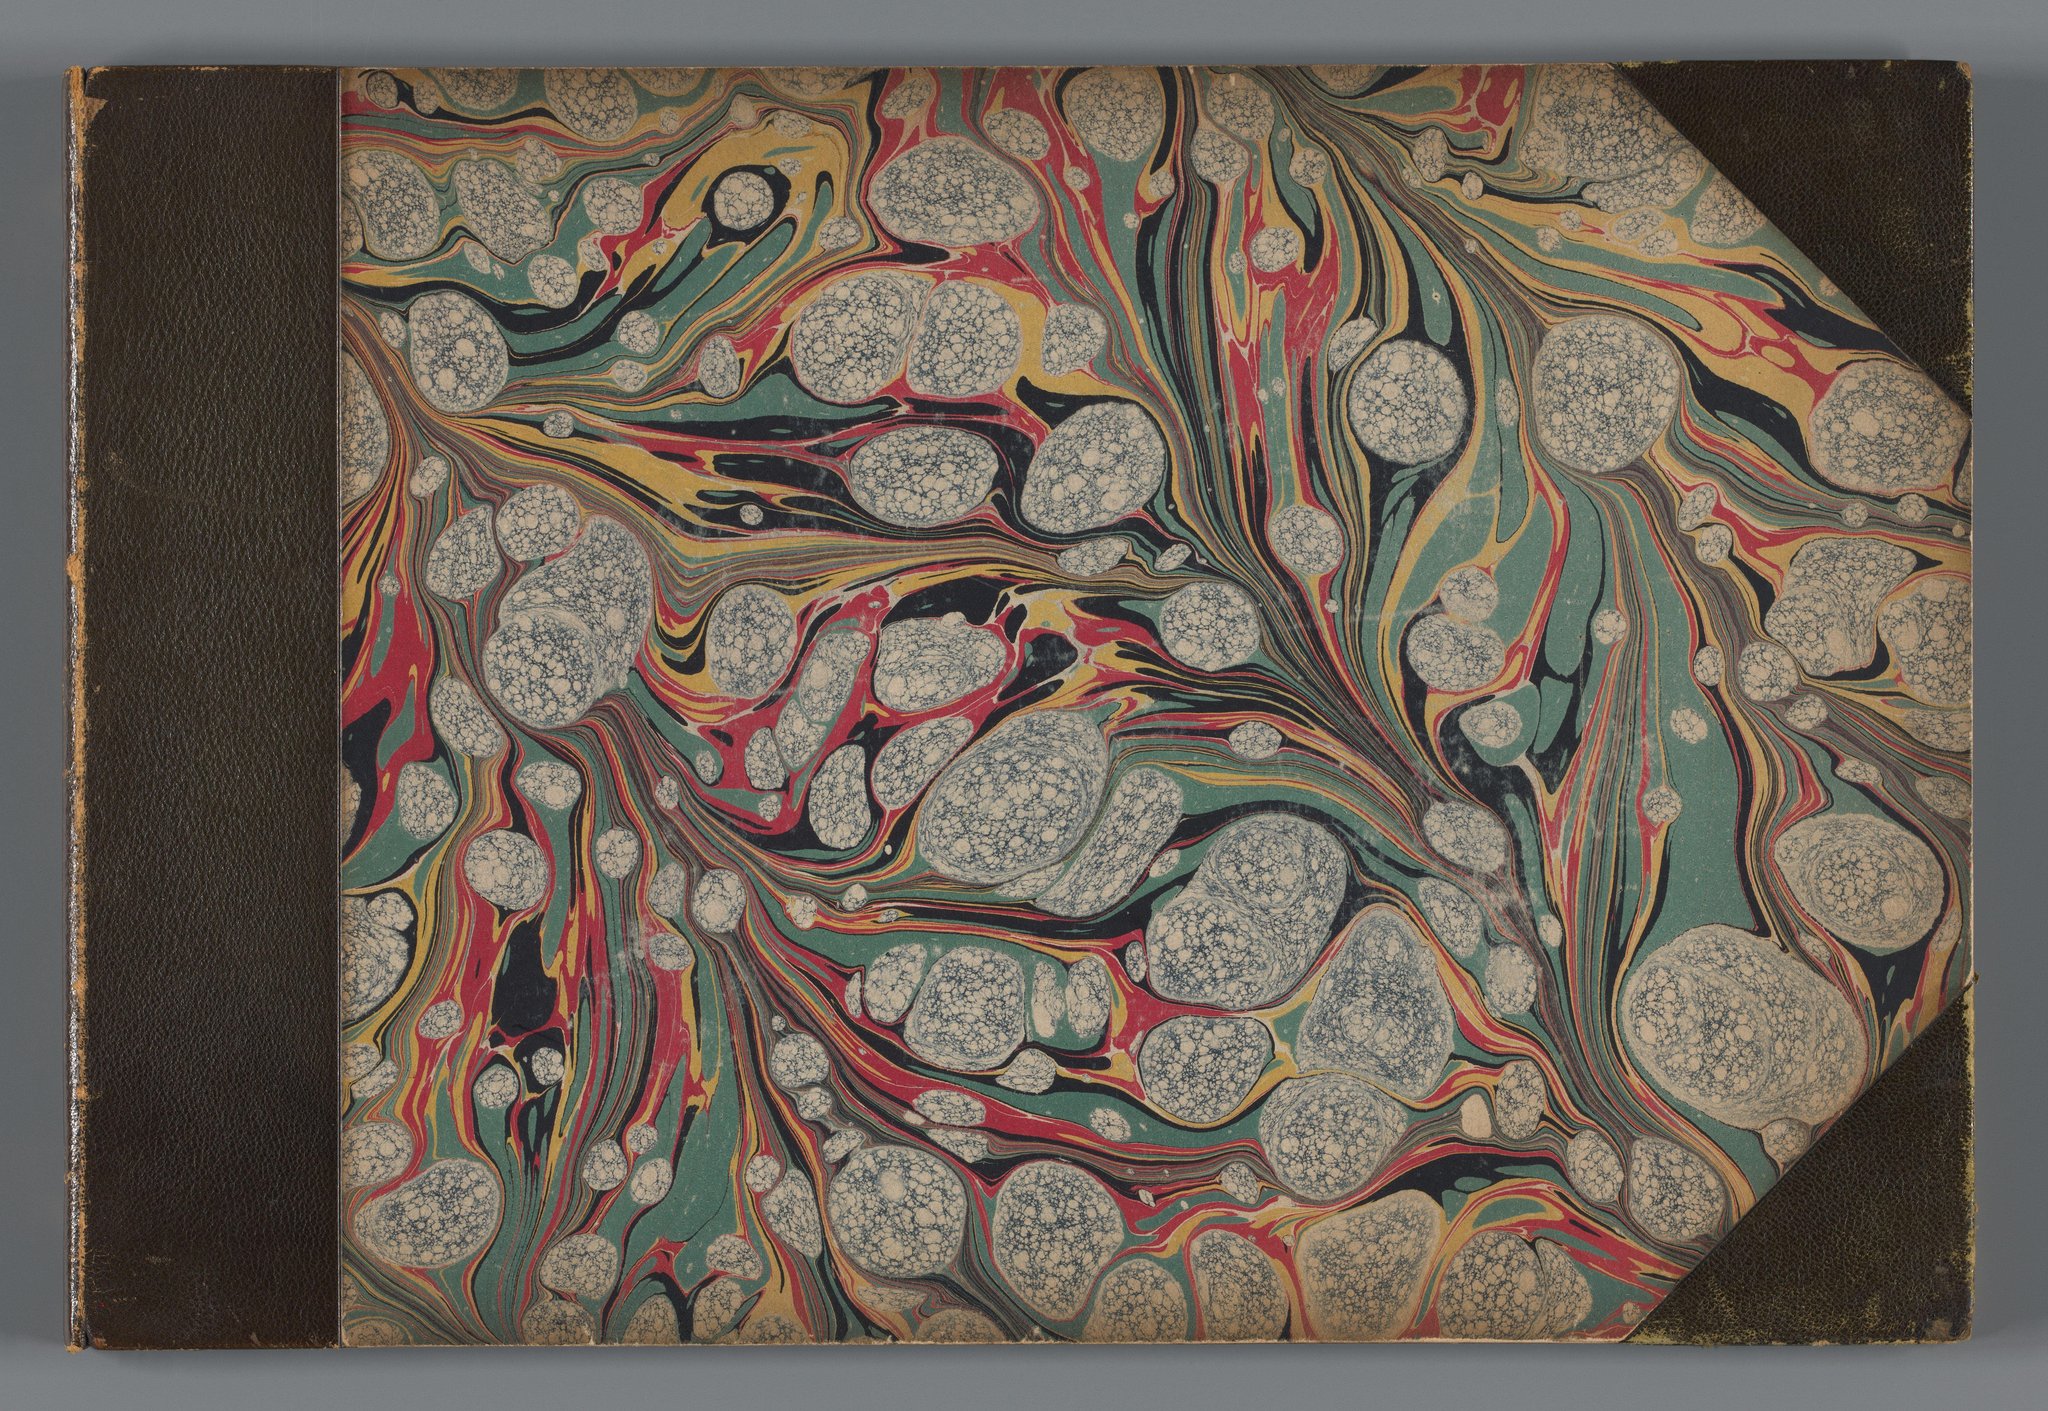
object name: prentrecueil, prentenalbum, prentalbum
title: Album met voorbeelden voor edelsmeden ontworpen door Johann Lorenz Hönnig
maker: johann lorenz hönnig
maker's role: print maker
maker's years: 1674-1713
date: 1707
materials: leather, paper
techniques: engraving, marbling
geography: nuremberg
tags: ornaments ~ art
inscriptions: collector's mark: ‘Assay Office Library Birmingham’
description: Prentalbum met zestien gravures op zestien bladen. Gebonden in latere band.